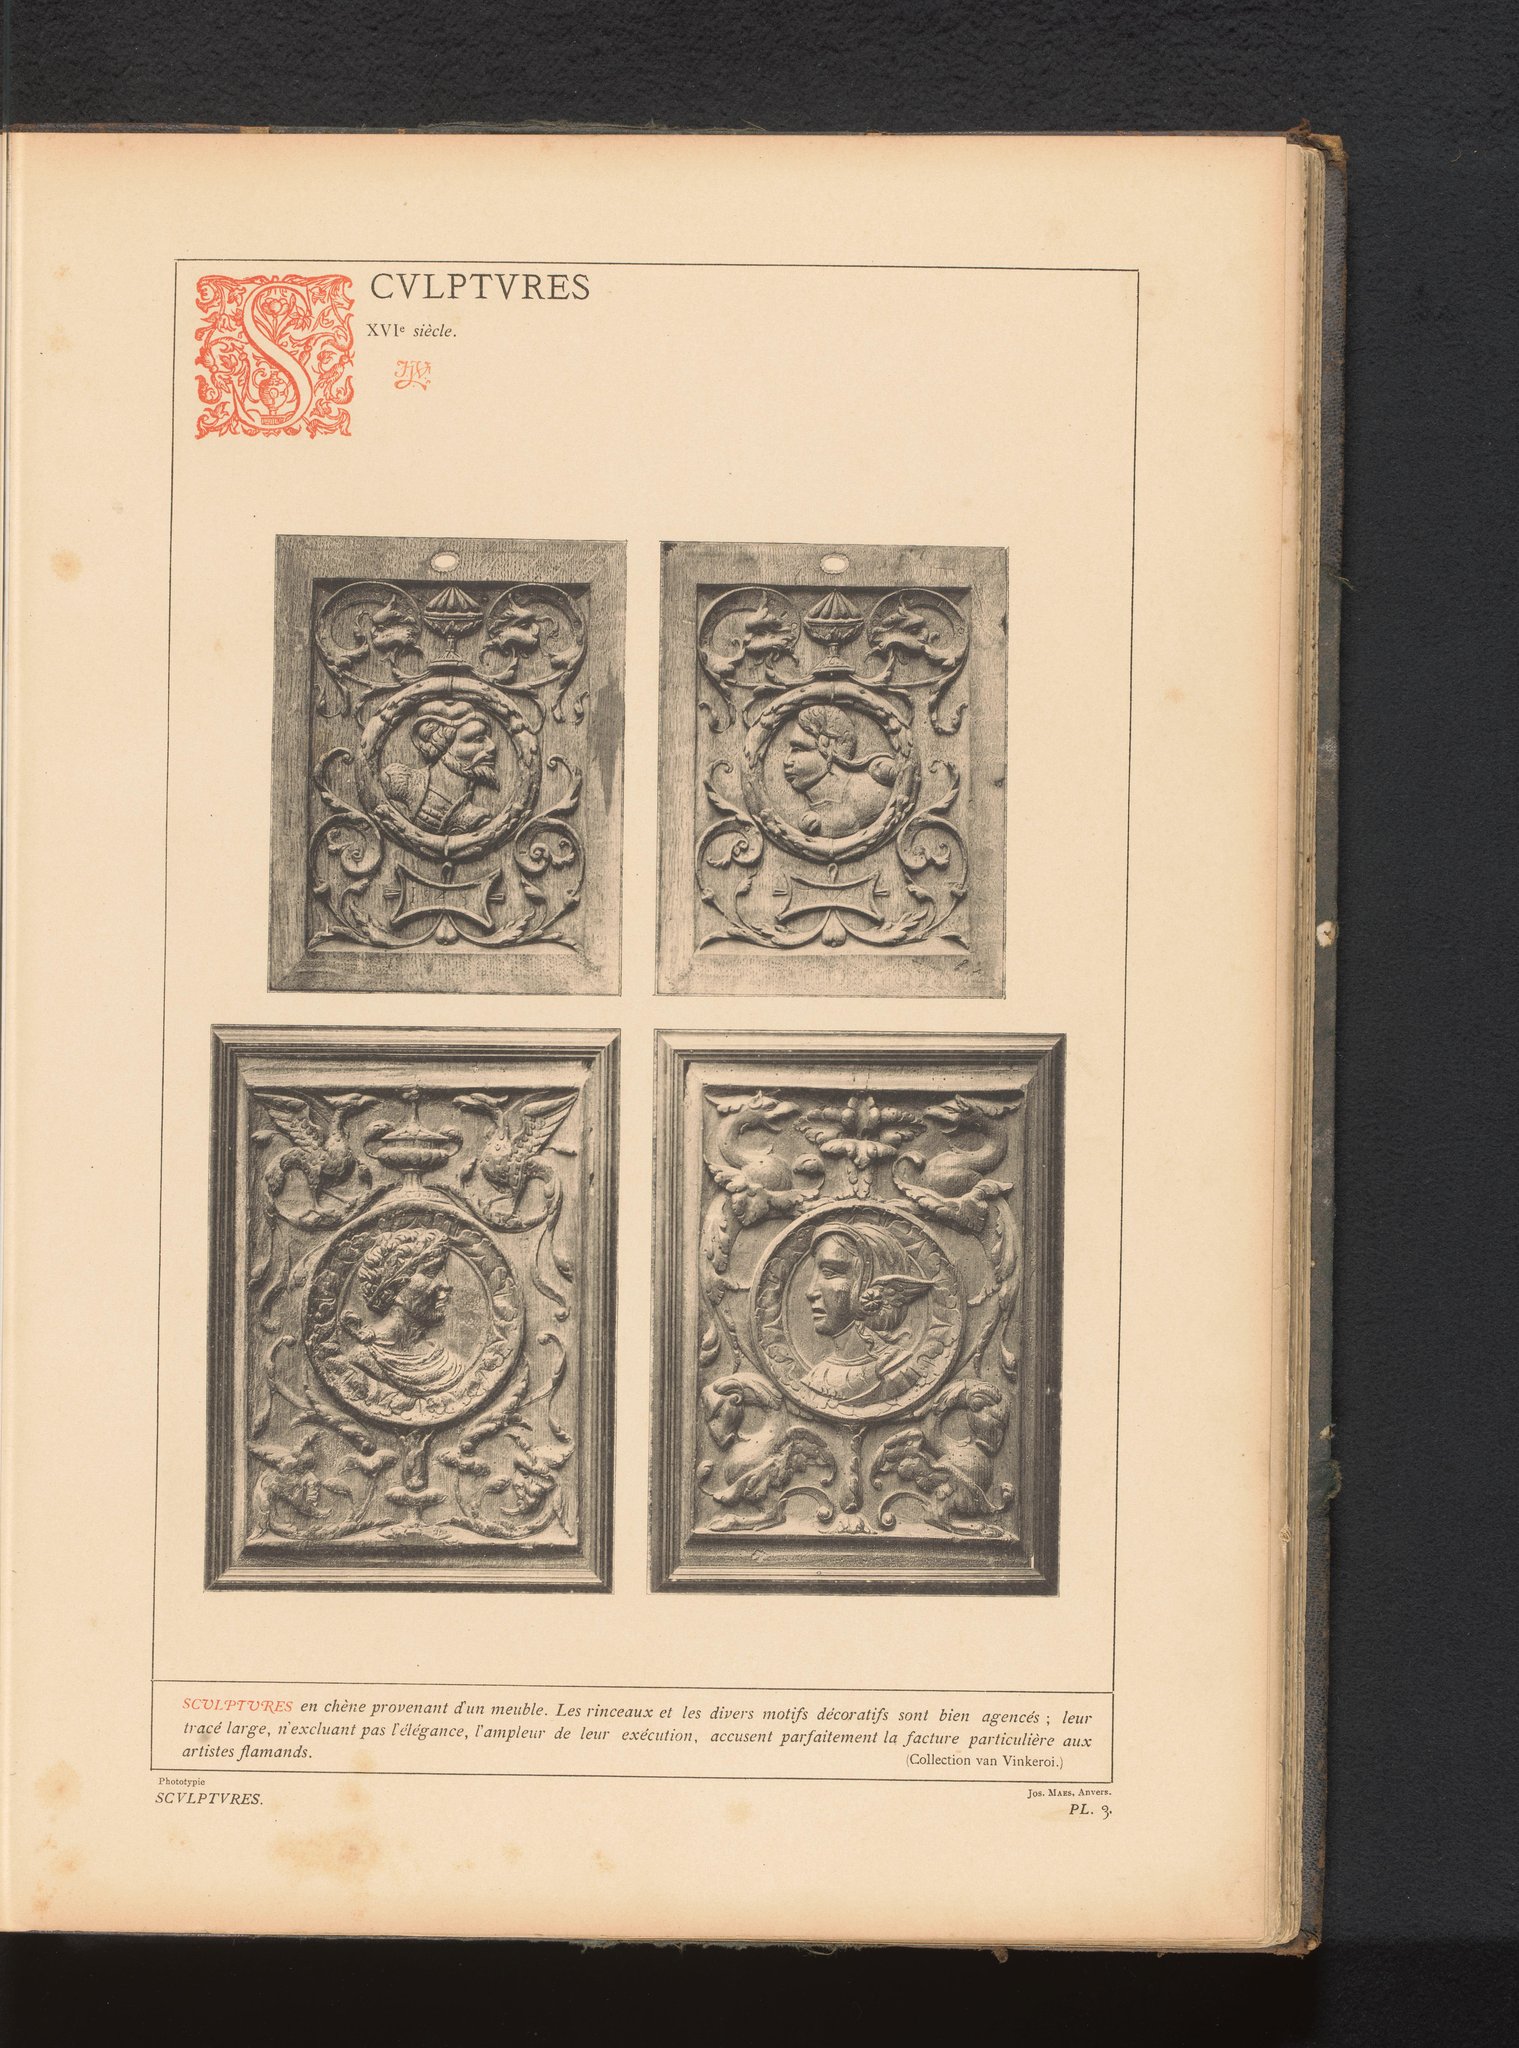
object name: page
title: Vier reliëfs van hout met een gezicht van een figuur en grotesken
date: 1882-1887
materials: paper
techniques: photograph, photolithography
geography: antwerp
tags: ornament ~ grotesque, head (human), sculpture (+ relief ~ sculpture)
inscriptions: inscription: ‘SCULPTURES en chène (...)’, monogram: ‘JJvY’, inscription: ‘SCULPTURES. - PL. 3.’